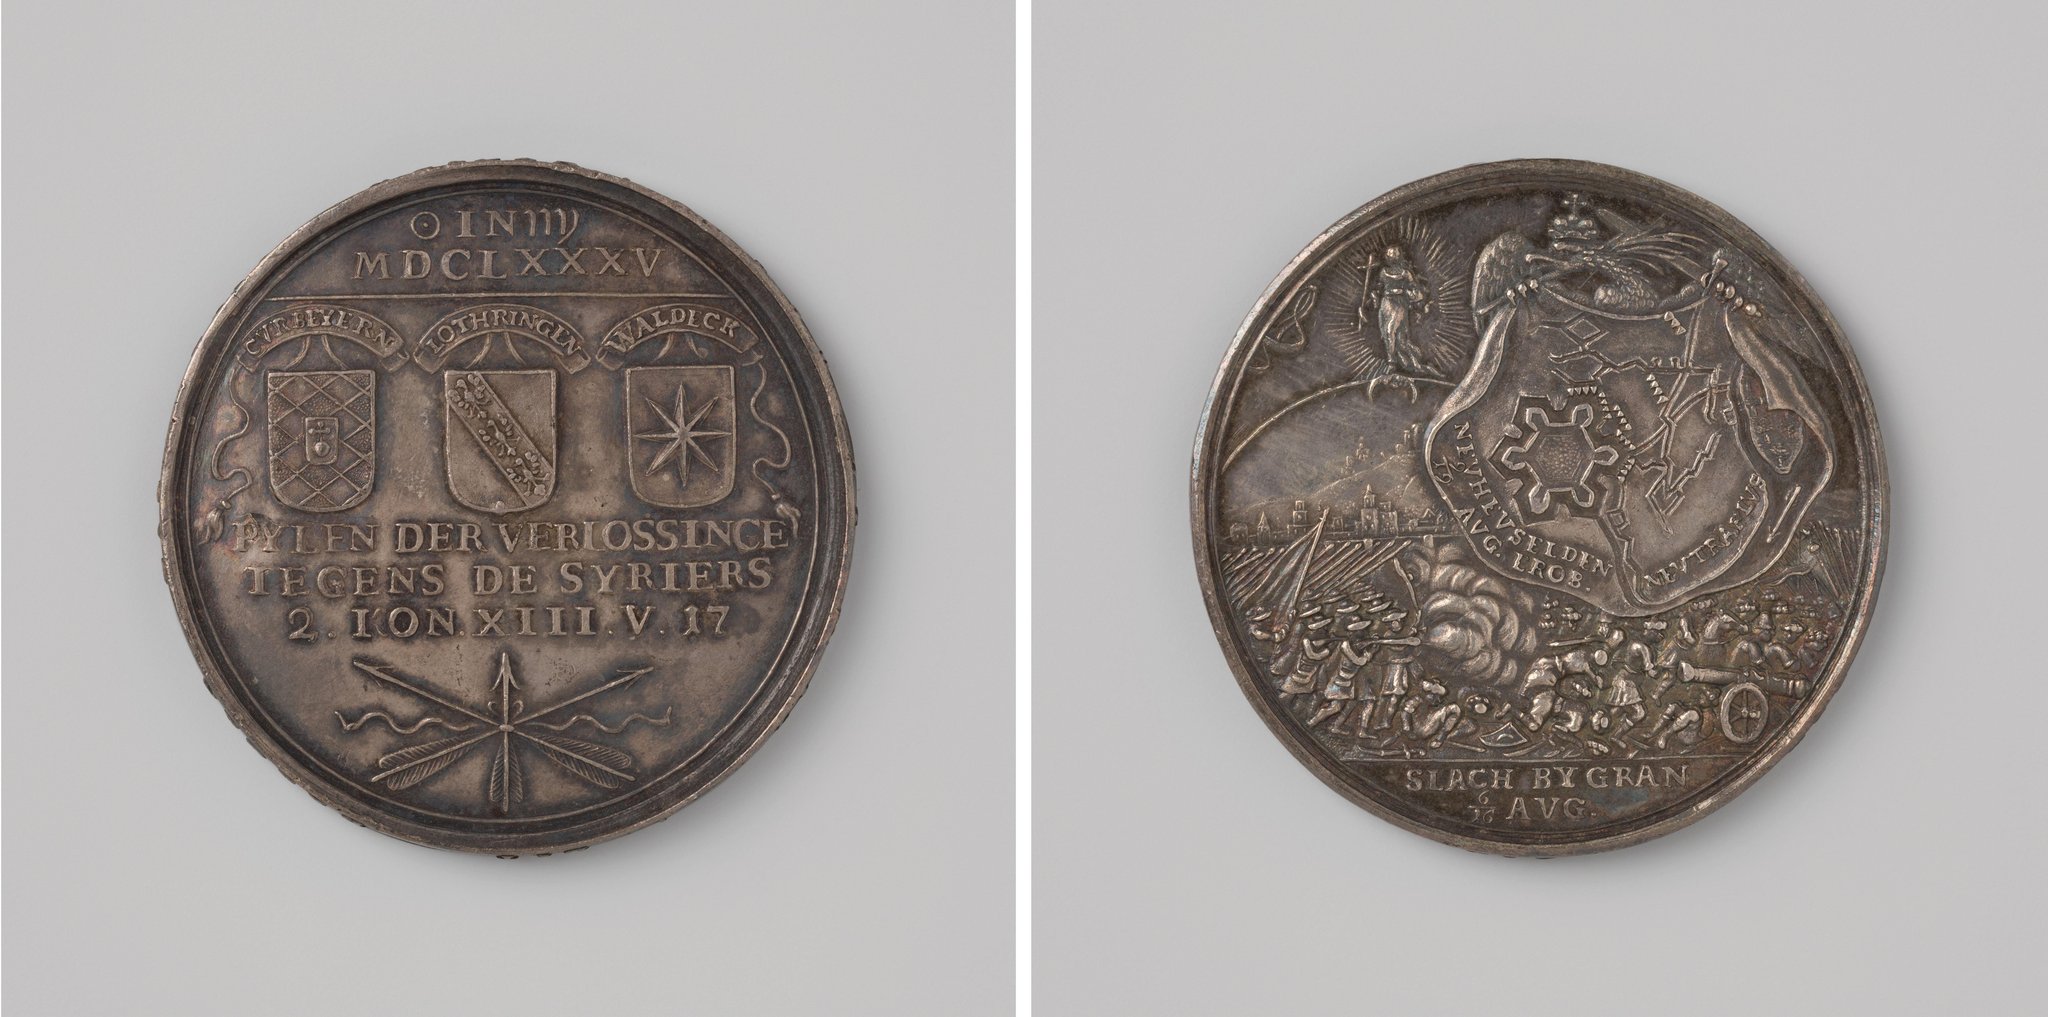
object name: history medal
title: Slag bij Gran en verovering van Neuhausel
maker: Anonymous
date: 1685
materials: silver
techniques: striking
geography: netherlands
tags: tsjechoslowakije, hongarije, esztergom, nové zámky, inname van gran, inname van neuhaeusel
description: Zilveren penning. Voorzijde: onder opschrift: drie wapenschilden, opschrift en drie samengebonden pijlen. Keerzijde: afbeelding van gevecht met op achtergrond stad en zwevende persoon met aureool, daarnaast door gekroonde adelaar met zwaard en palmtak vastgehouden doek met plattegrond van stad boven opschrift; randschrift